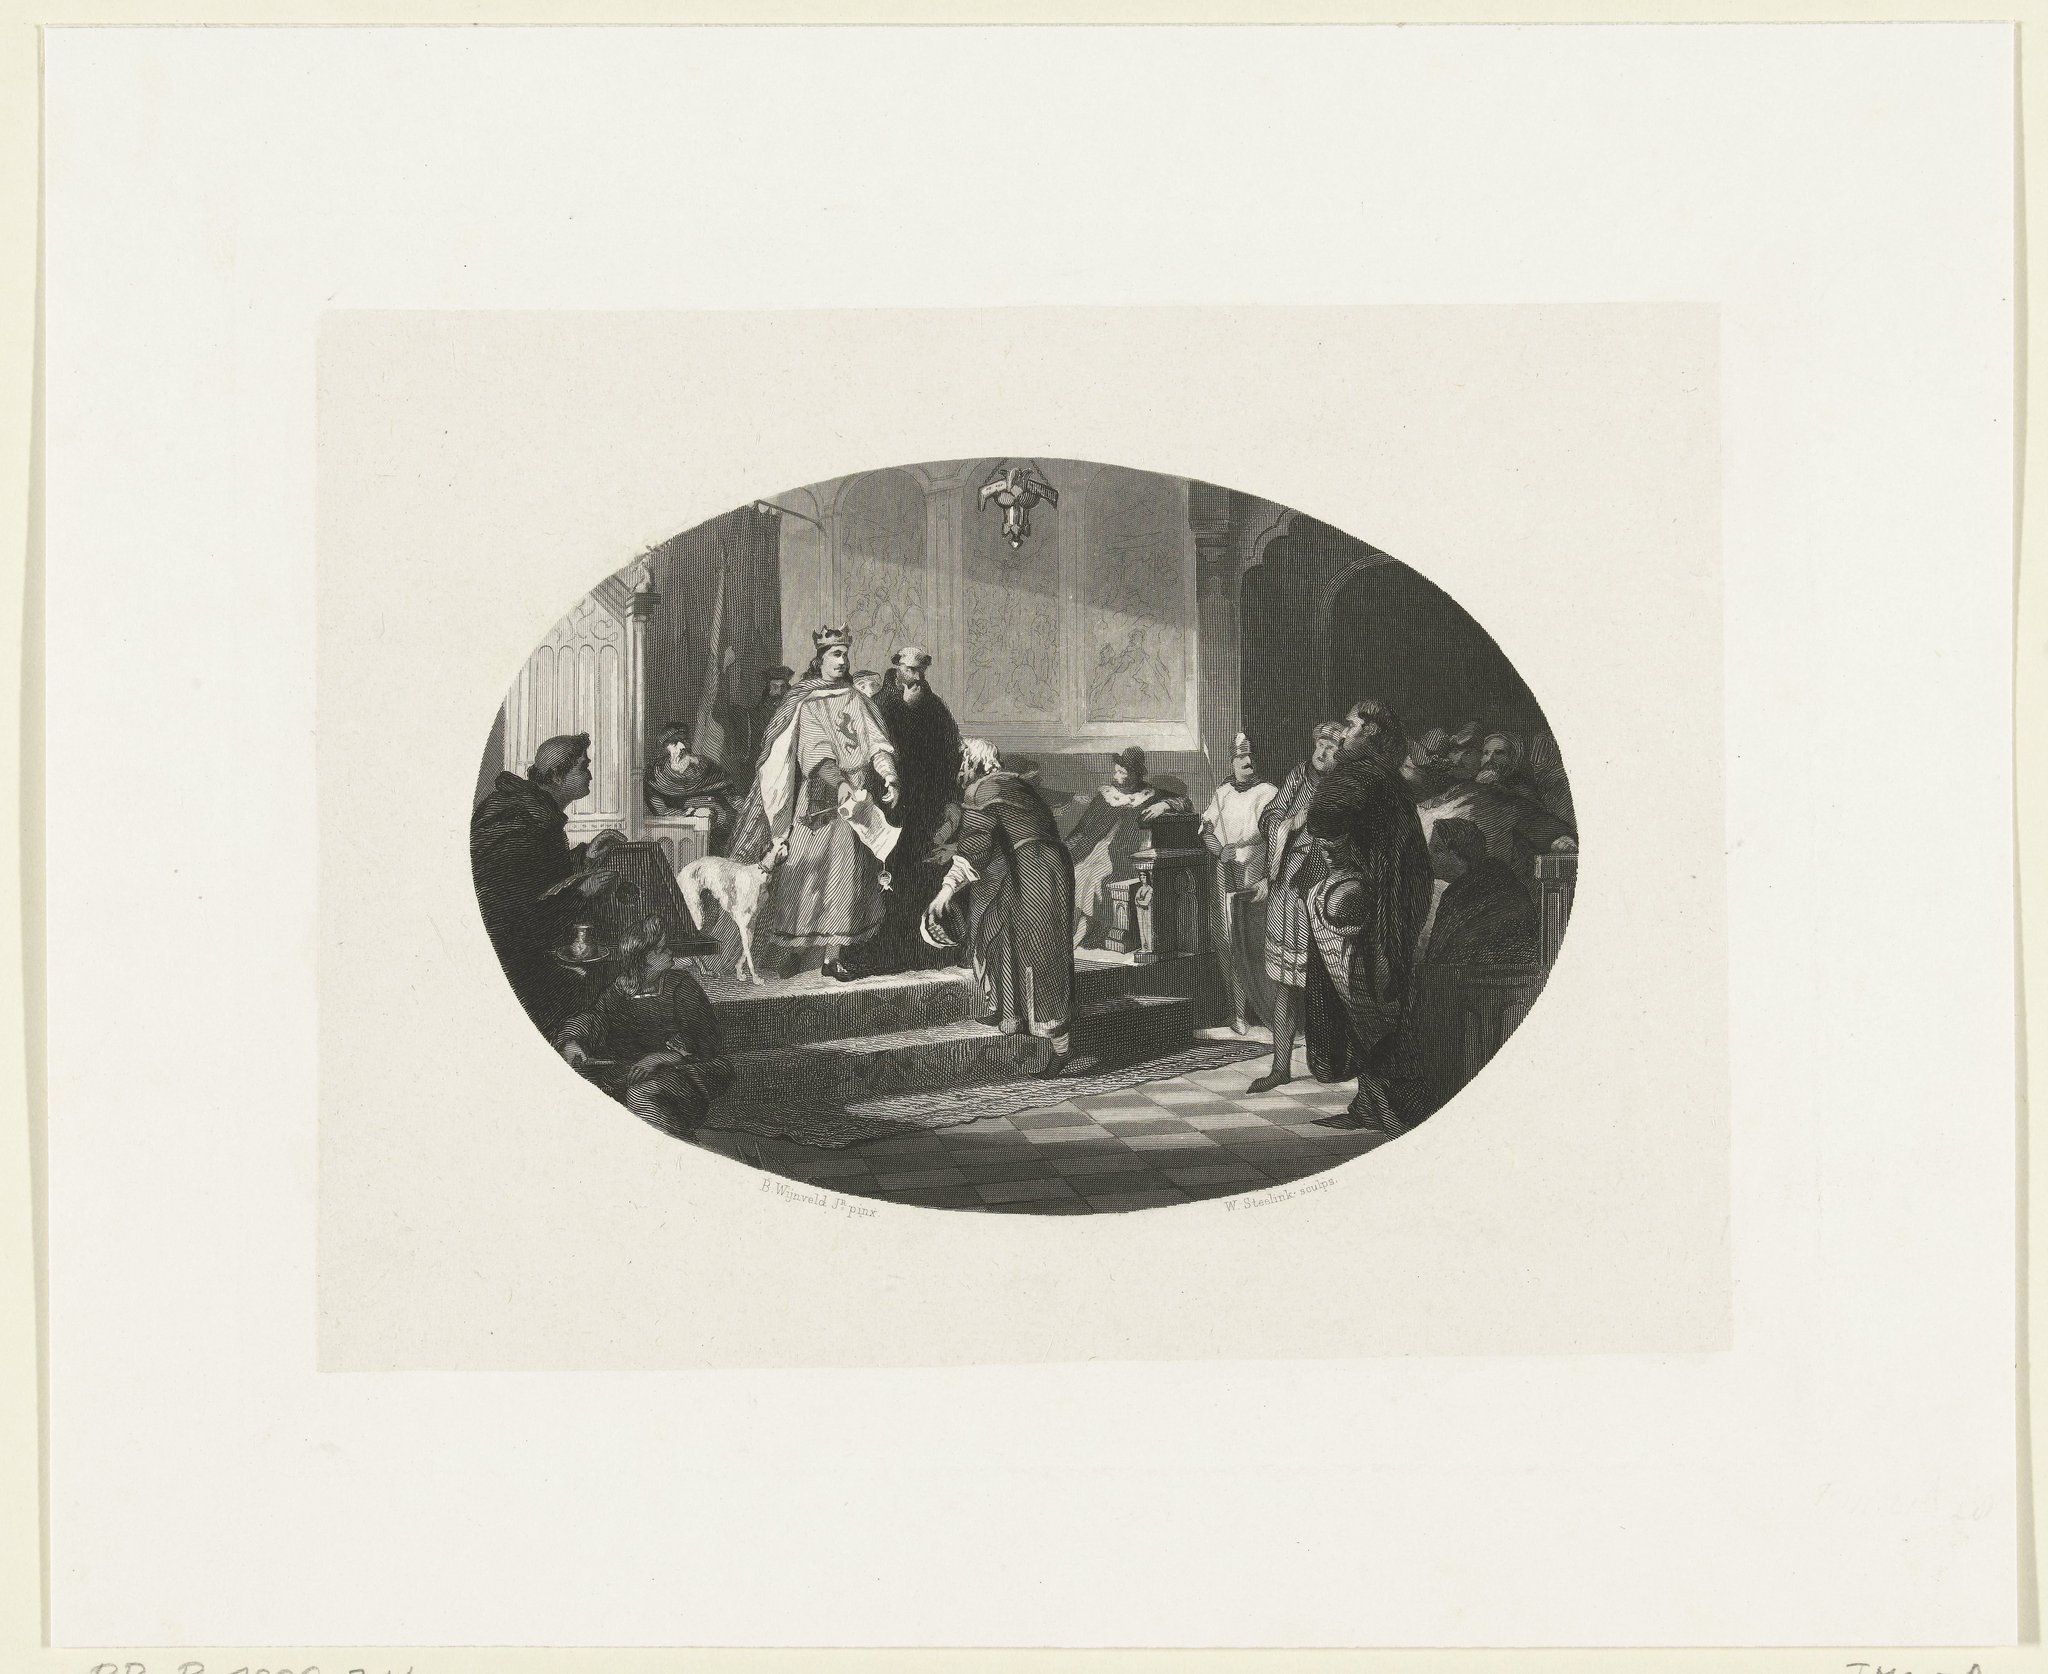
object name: history print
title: Amsterdam tot stad verheven, ca. 1335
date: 1865-1870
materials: paper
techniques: engraving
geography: netherlands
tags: netherlands, amsterdam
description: Illustratie voor: J. van Lennep en W. Moll en J. ter Gouw, Nederlands geschiedenis en volksleven in schetsen, A.W. Sijthoff, Leiden ca. 1870, pl. 28. Staalgravures naar de schilderijen van de Historische Galerij der Maatschappij Arti en Amicitiae.